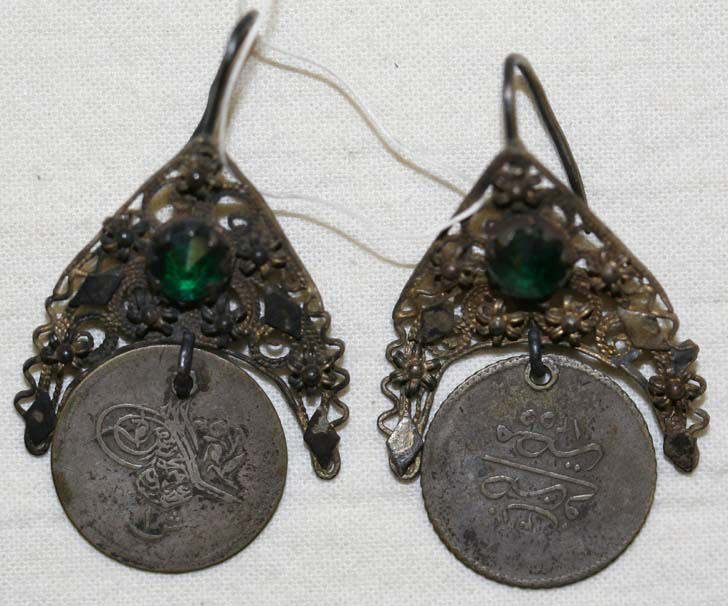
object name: earring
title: Earrings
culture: croatian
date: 1701-1900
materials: metal